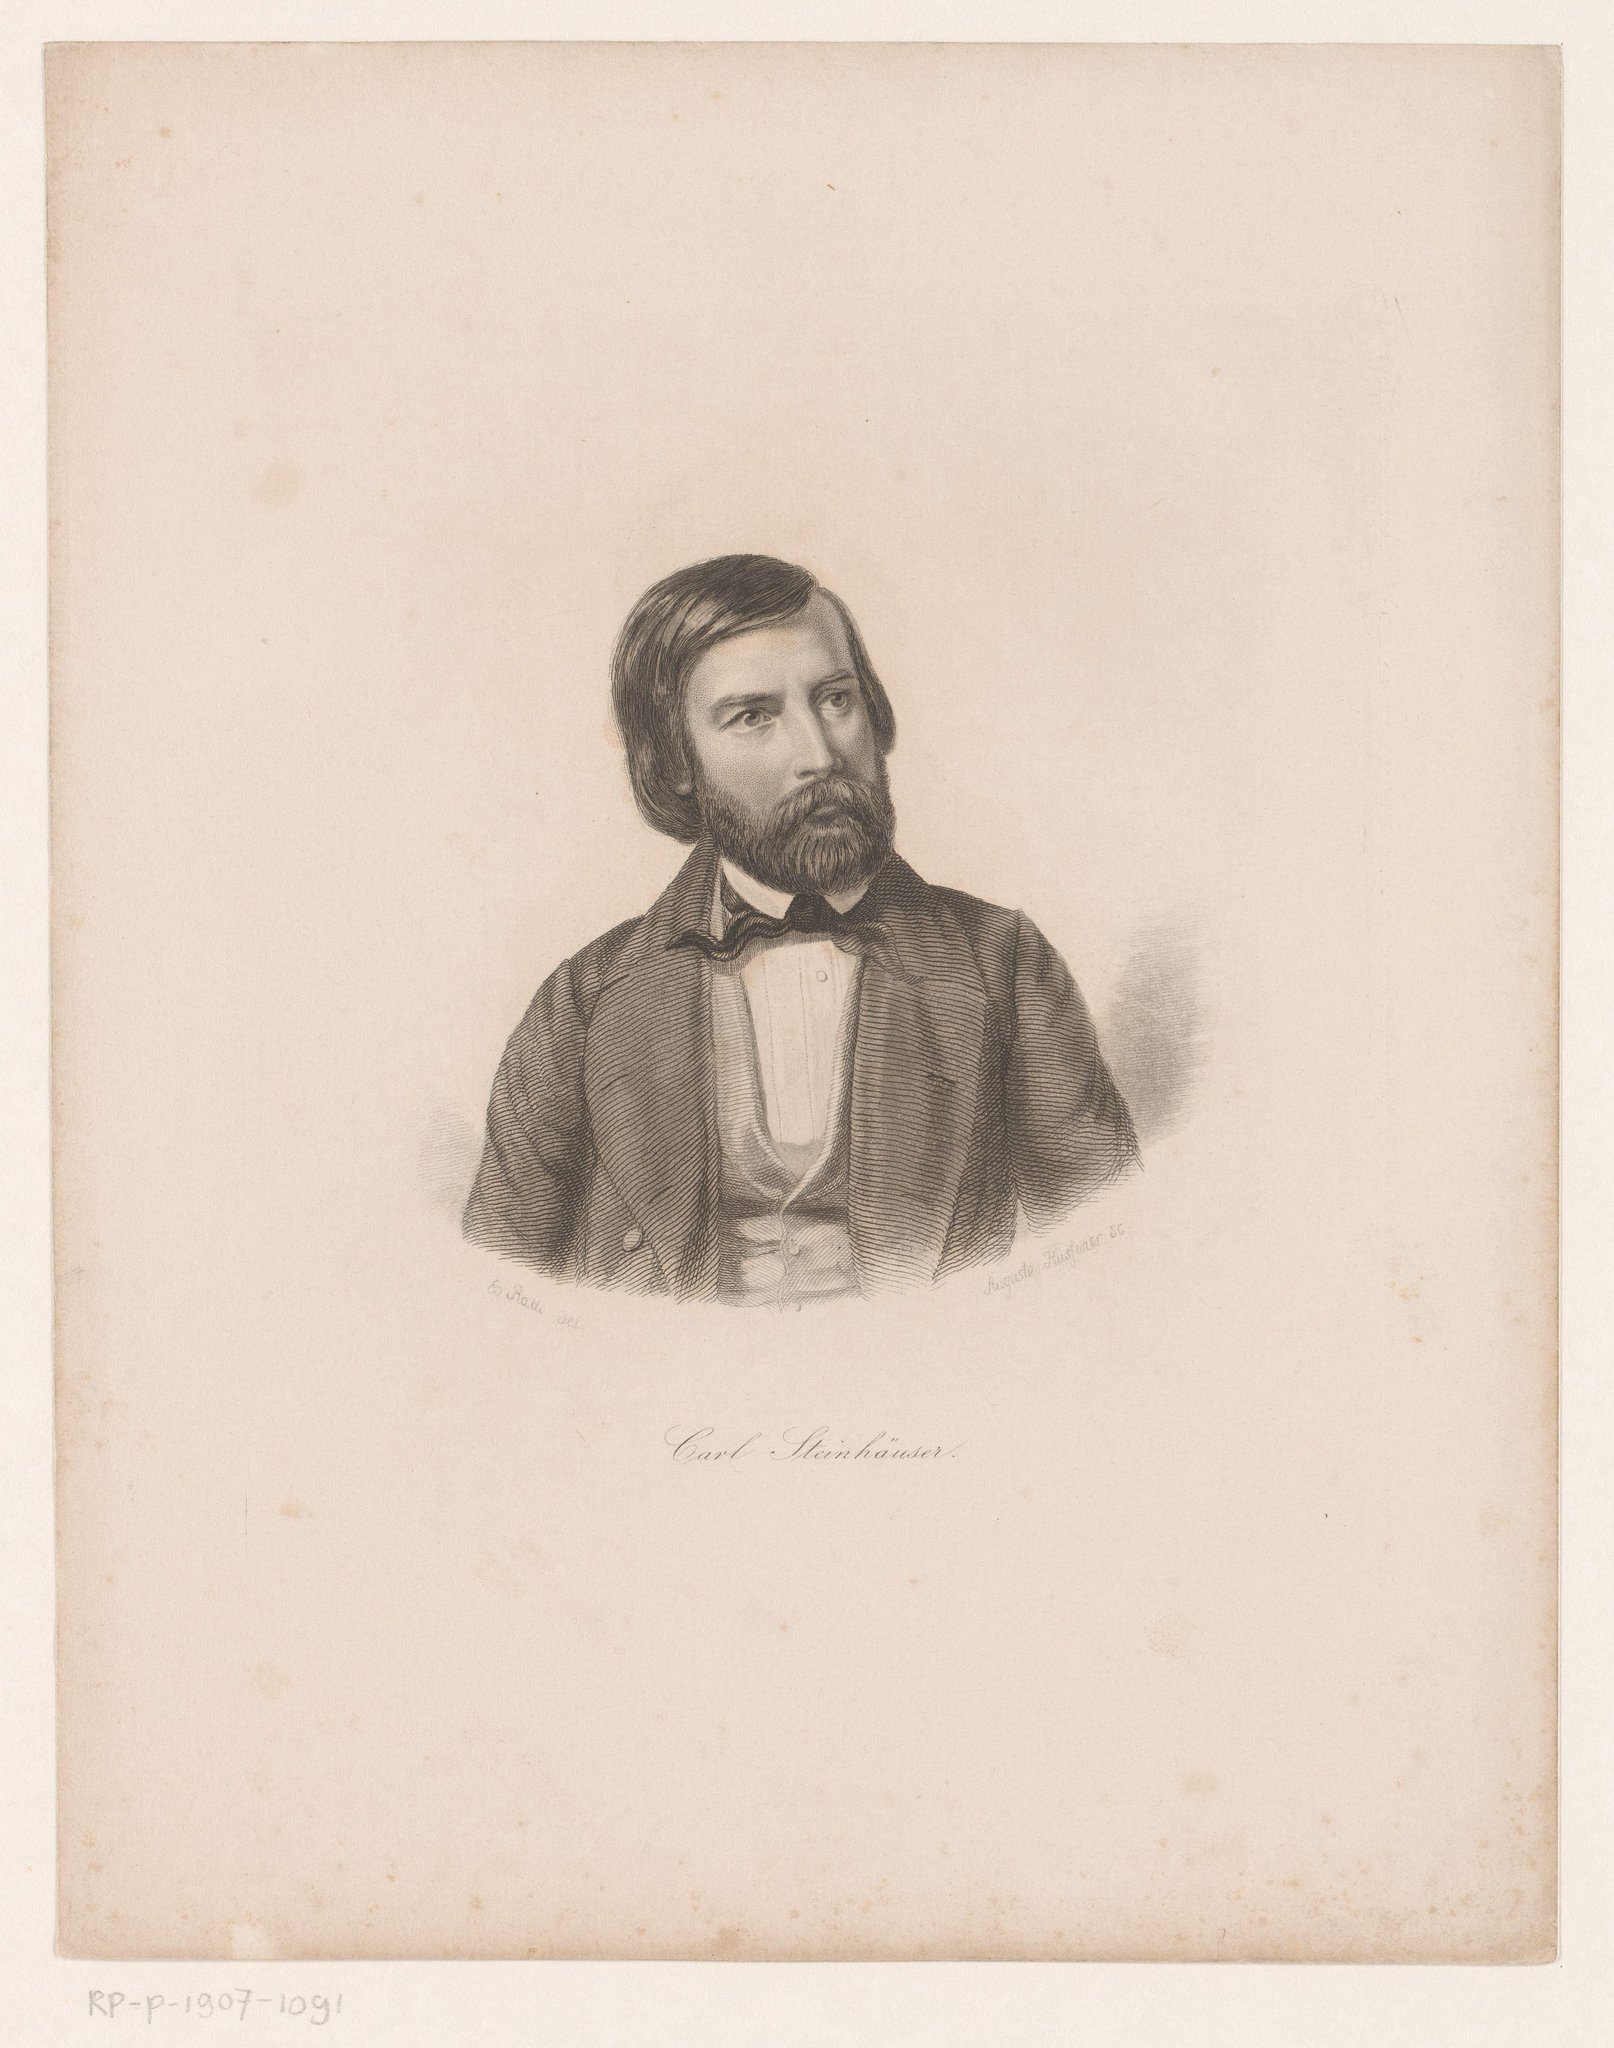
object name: print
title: Portret van Carl Steinhäuser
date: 1826-1877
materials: paper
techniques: engraving, etching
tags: sculptor, portrait, self-portrait of sculptor, historical persons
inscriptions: collector's mark: Lugt 2228